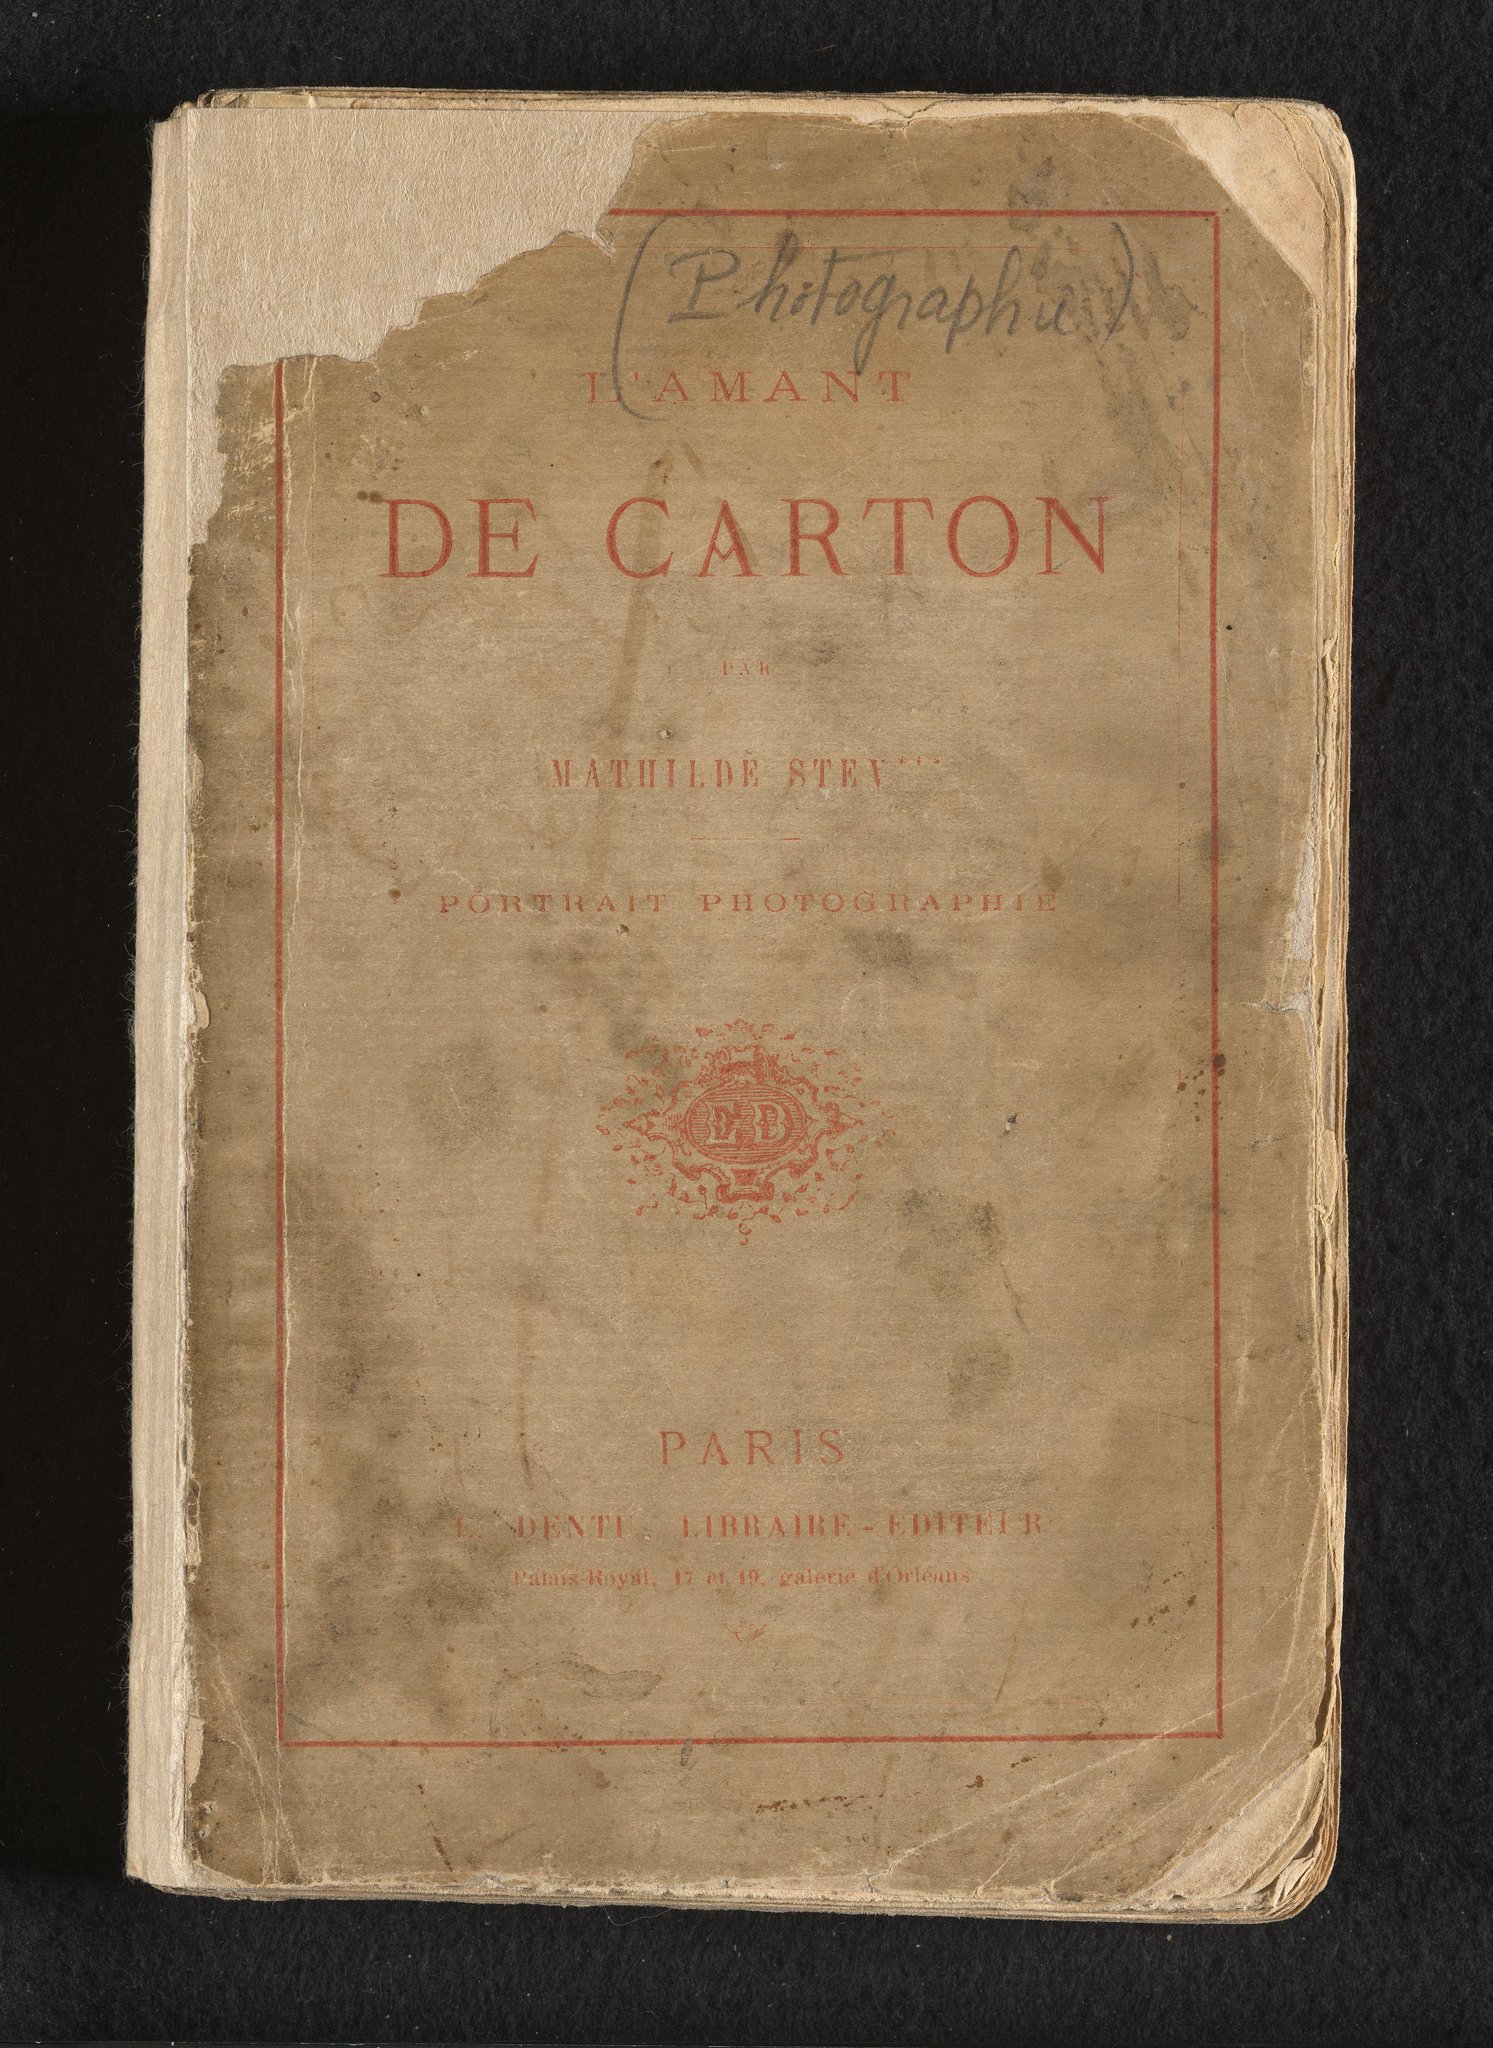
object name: book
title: L'amant de carton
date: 1863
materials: cardboard, paper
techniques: albumen print, printing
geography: paris